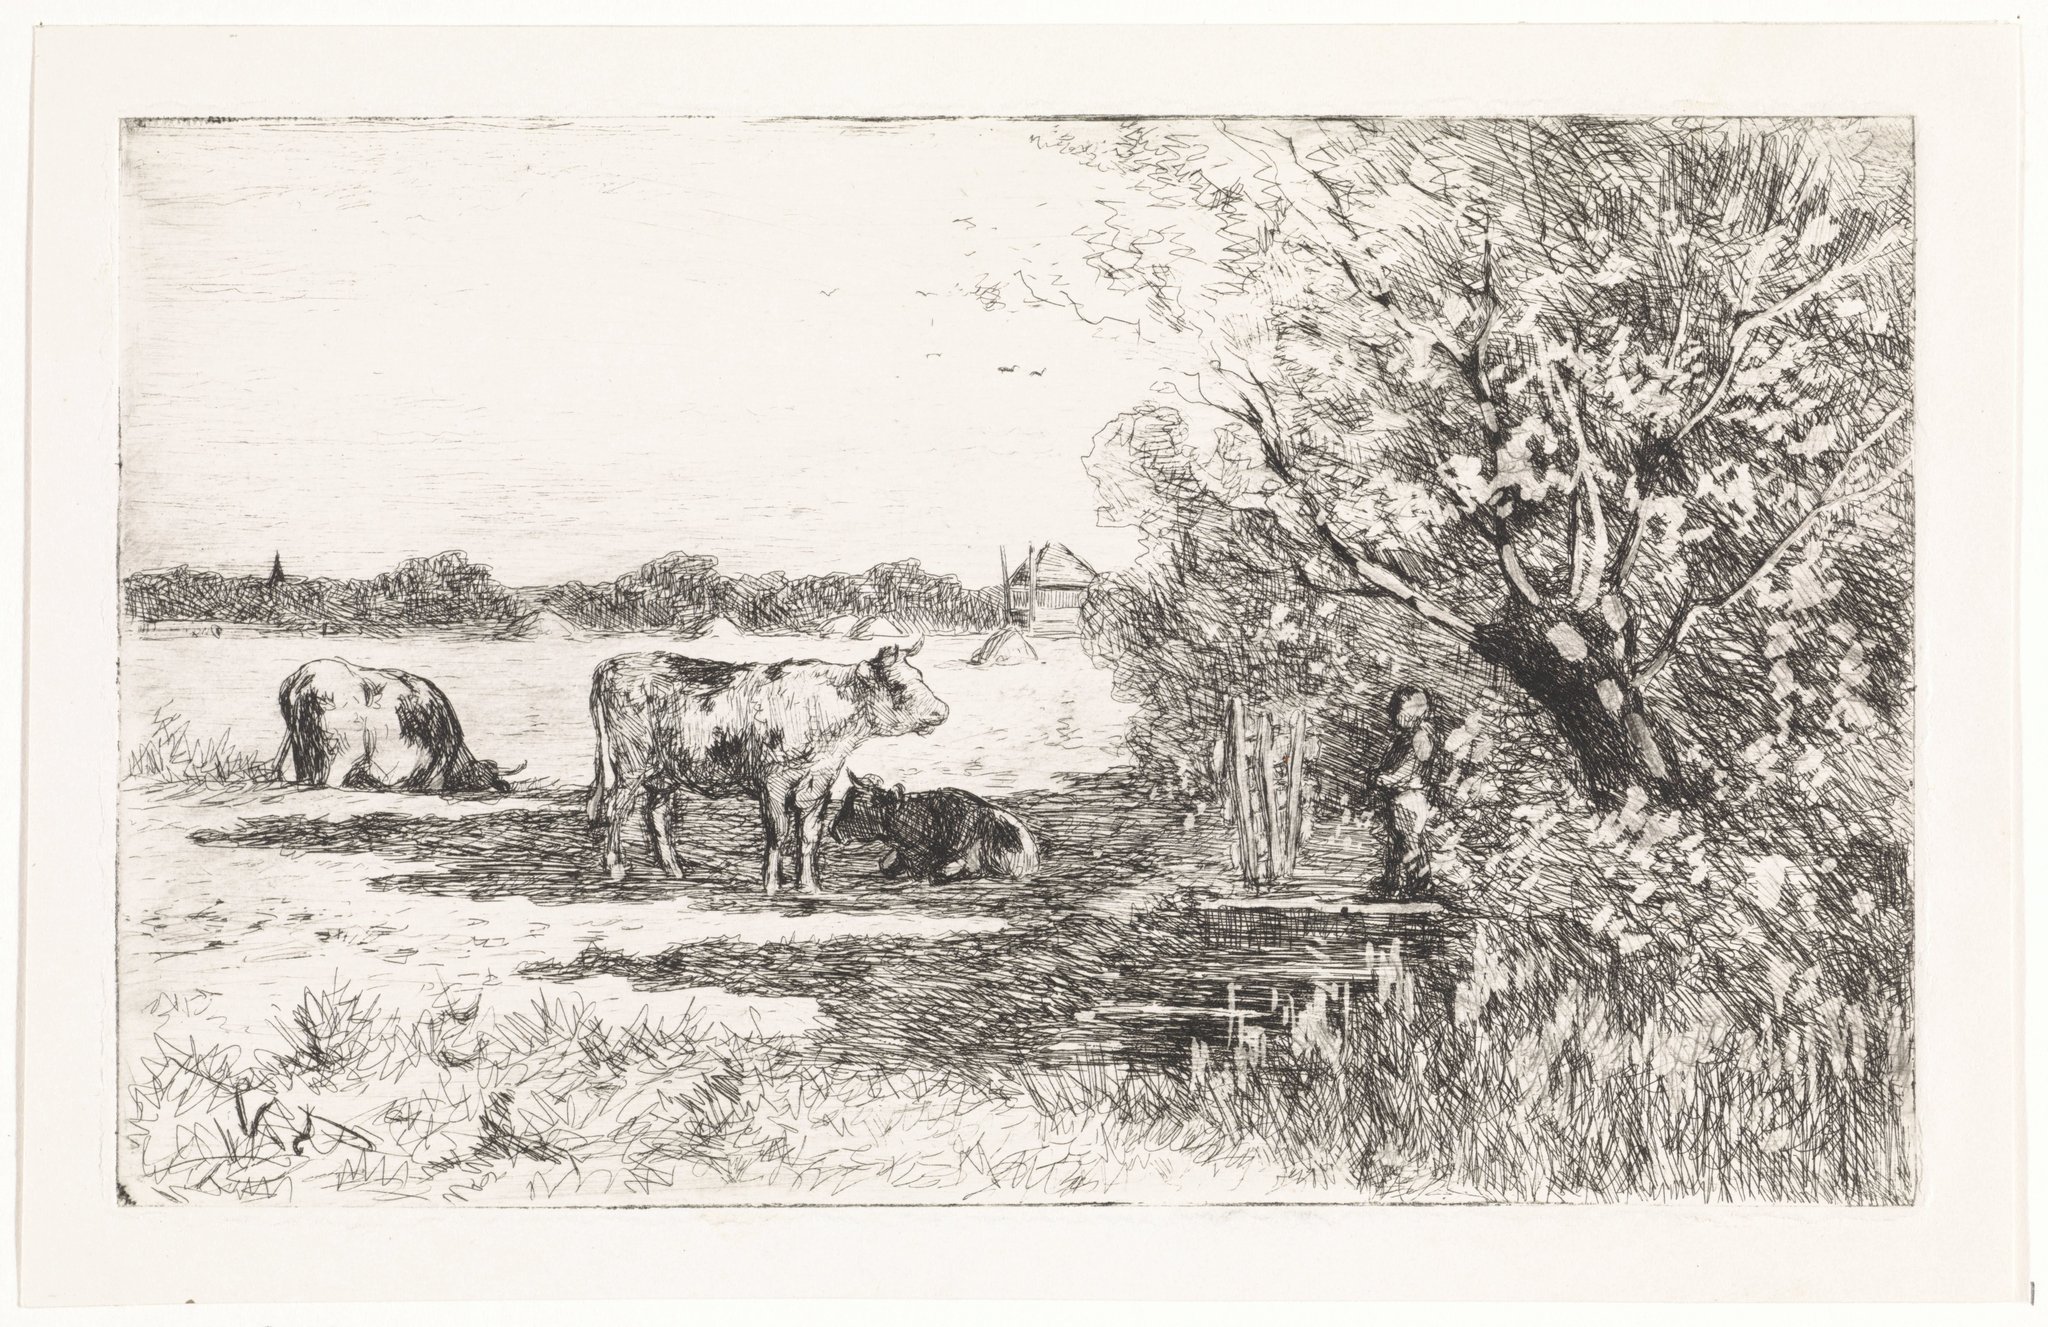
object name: print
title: Koeien in weiland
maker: jan vrolijk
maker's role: draughtsman, painter, print maker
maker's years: 1846-1894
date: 1860-1885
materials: paper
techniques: etching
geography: the hague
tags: cow, hay-stack, trees: willow, pond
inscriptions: collector's mark: Lugt 2228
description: Koeien staan in een weiland bij een vijver. Een kind bij het hek kijkt naar hen. Op de achtergrond een hooischuur.